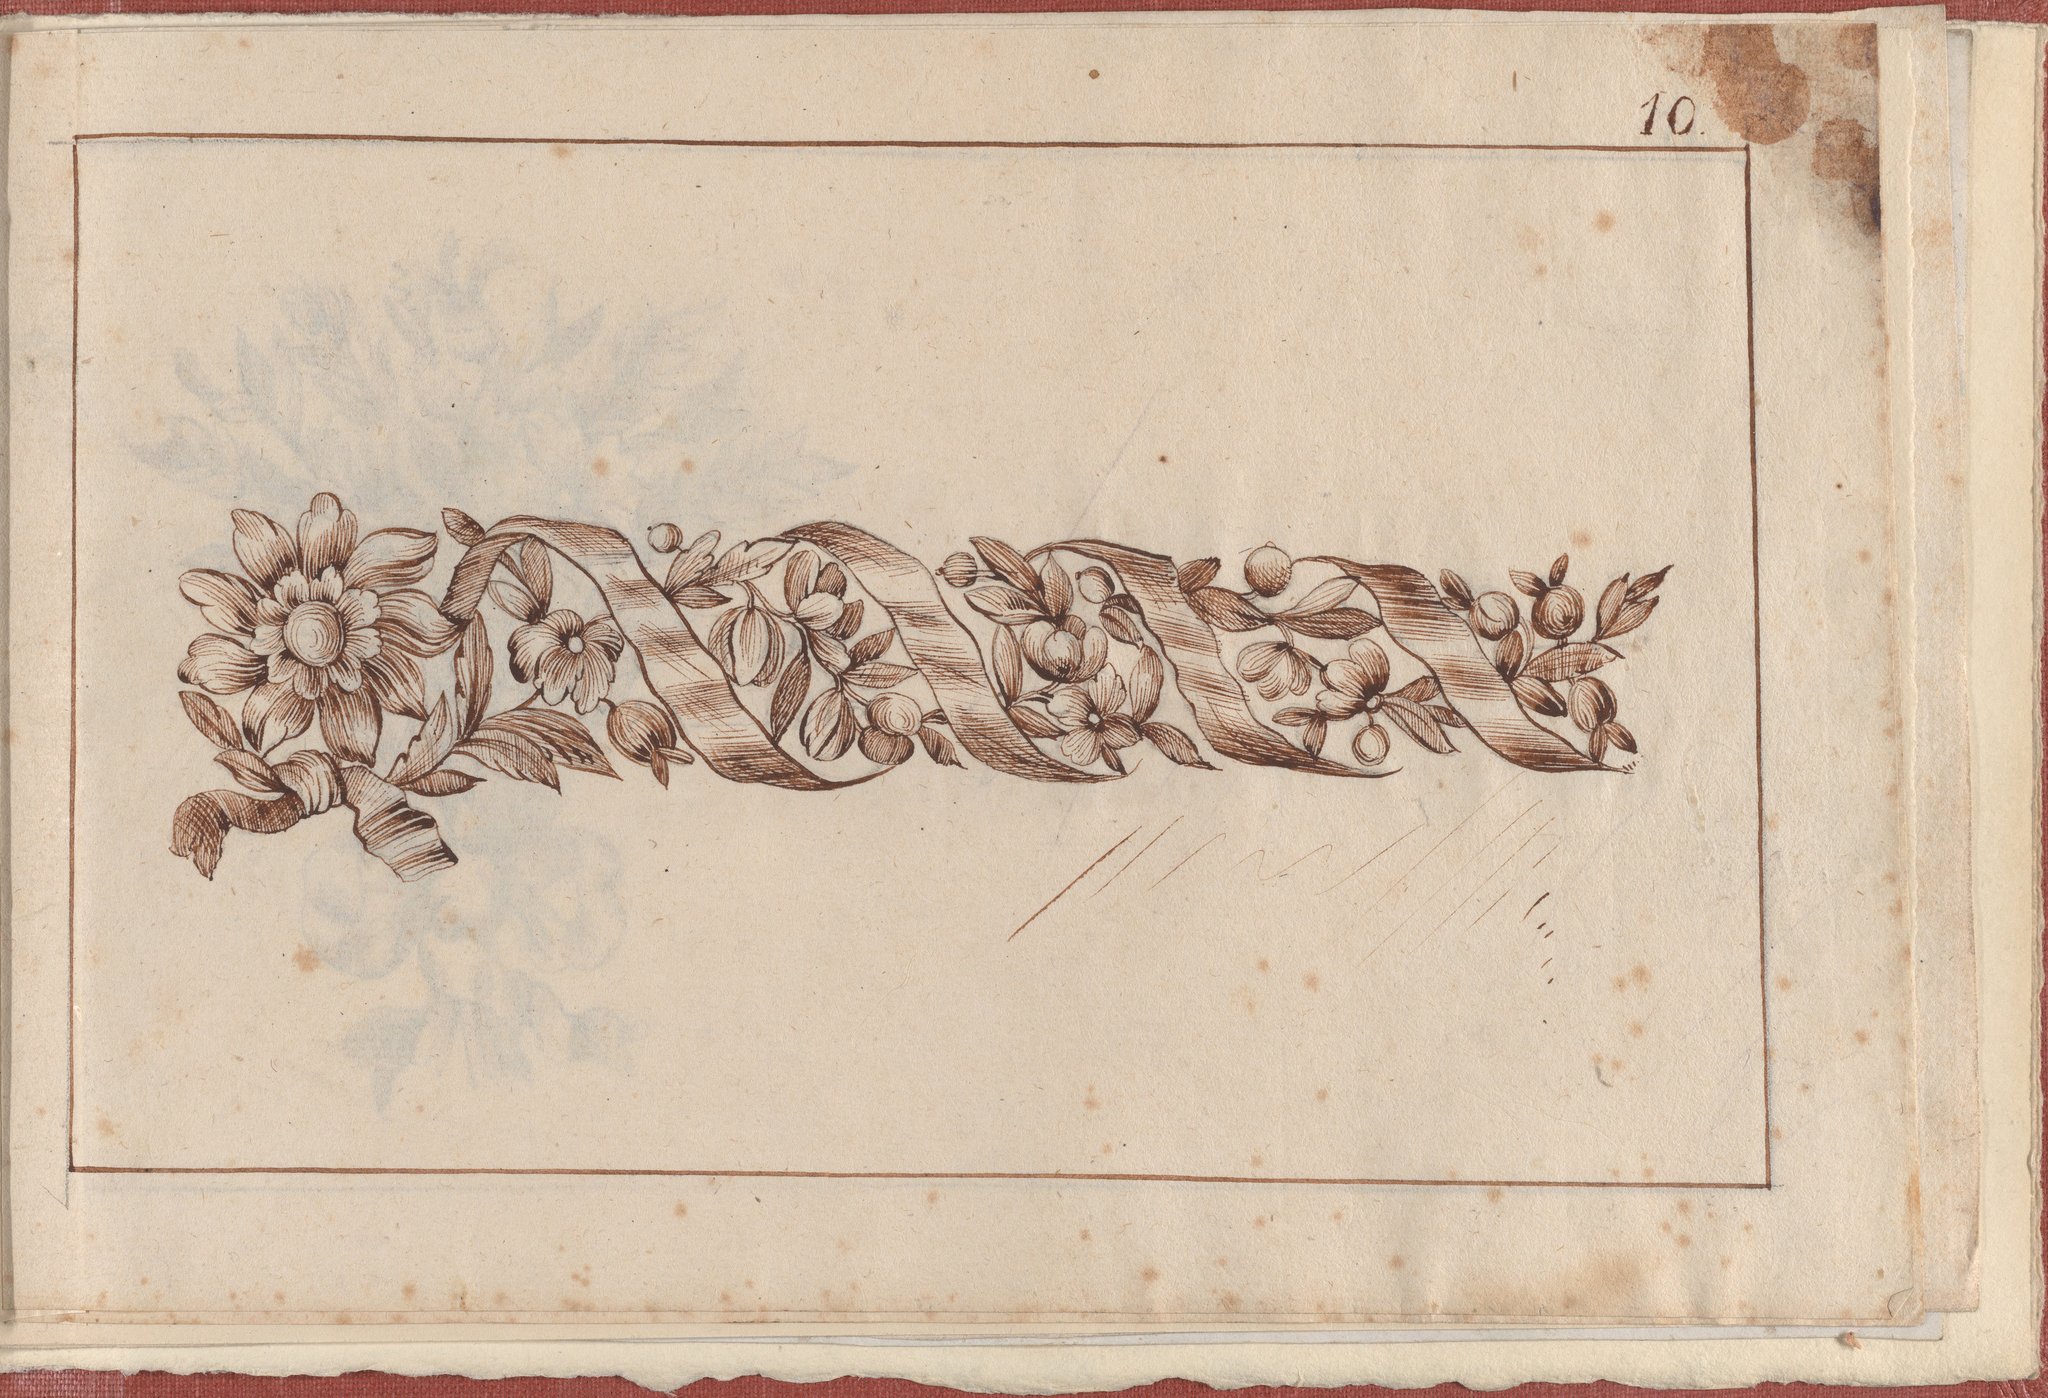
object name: album print ornament architecture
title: Joaillerie: Album of Jewelry Designs, Page 10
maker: anonymous, french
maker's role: artist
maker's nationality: french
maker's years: 1400-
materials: ink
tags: jewelry